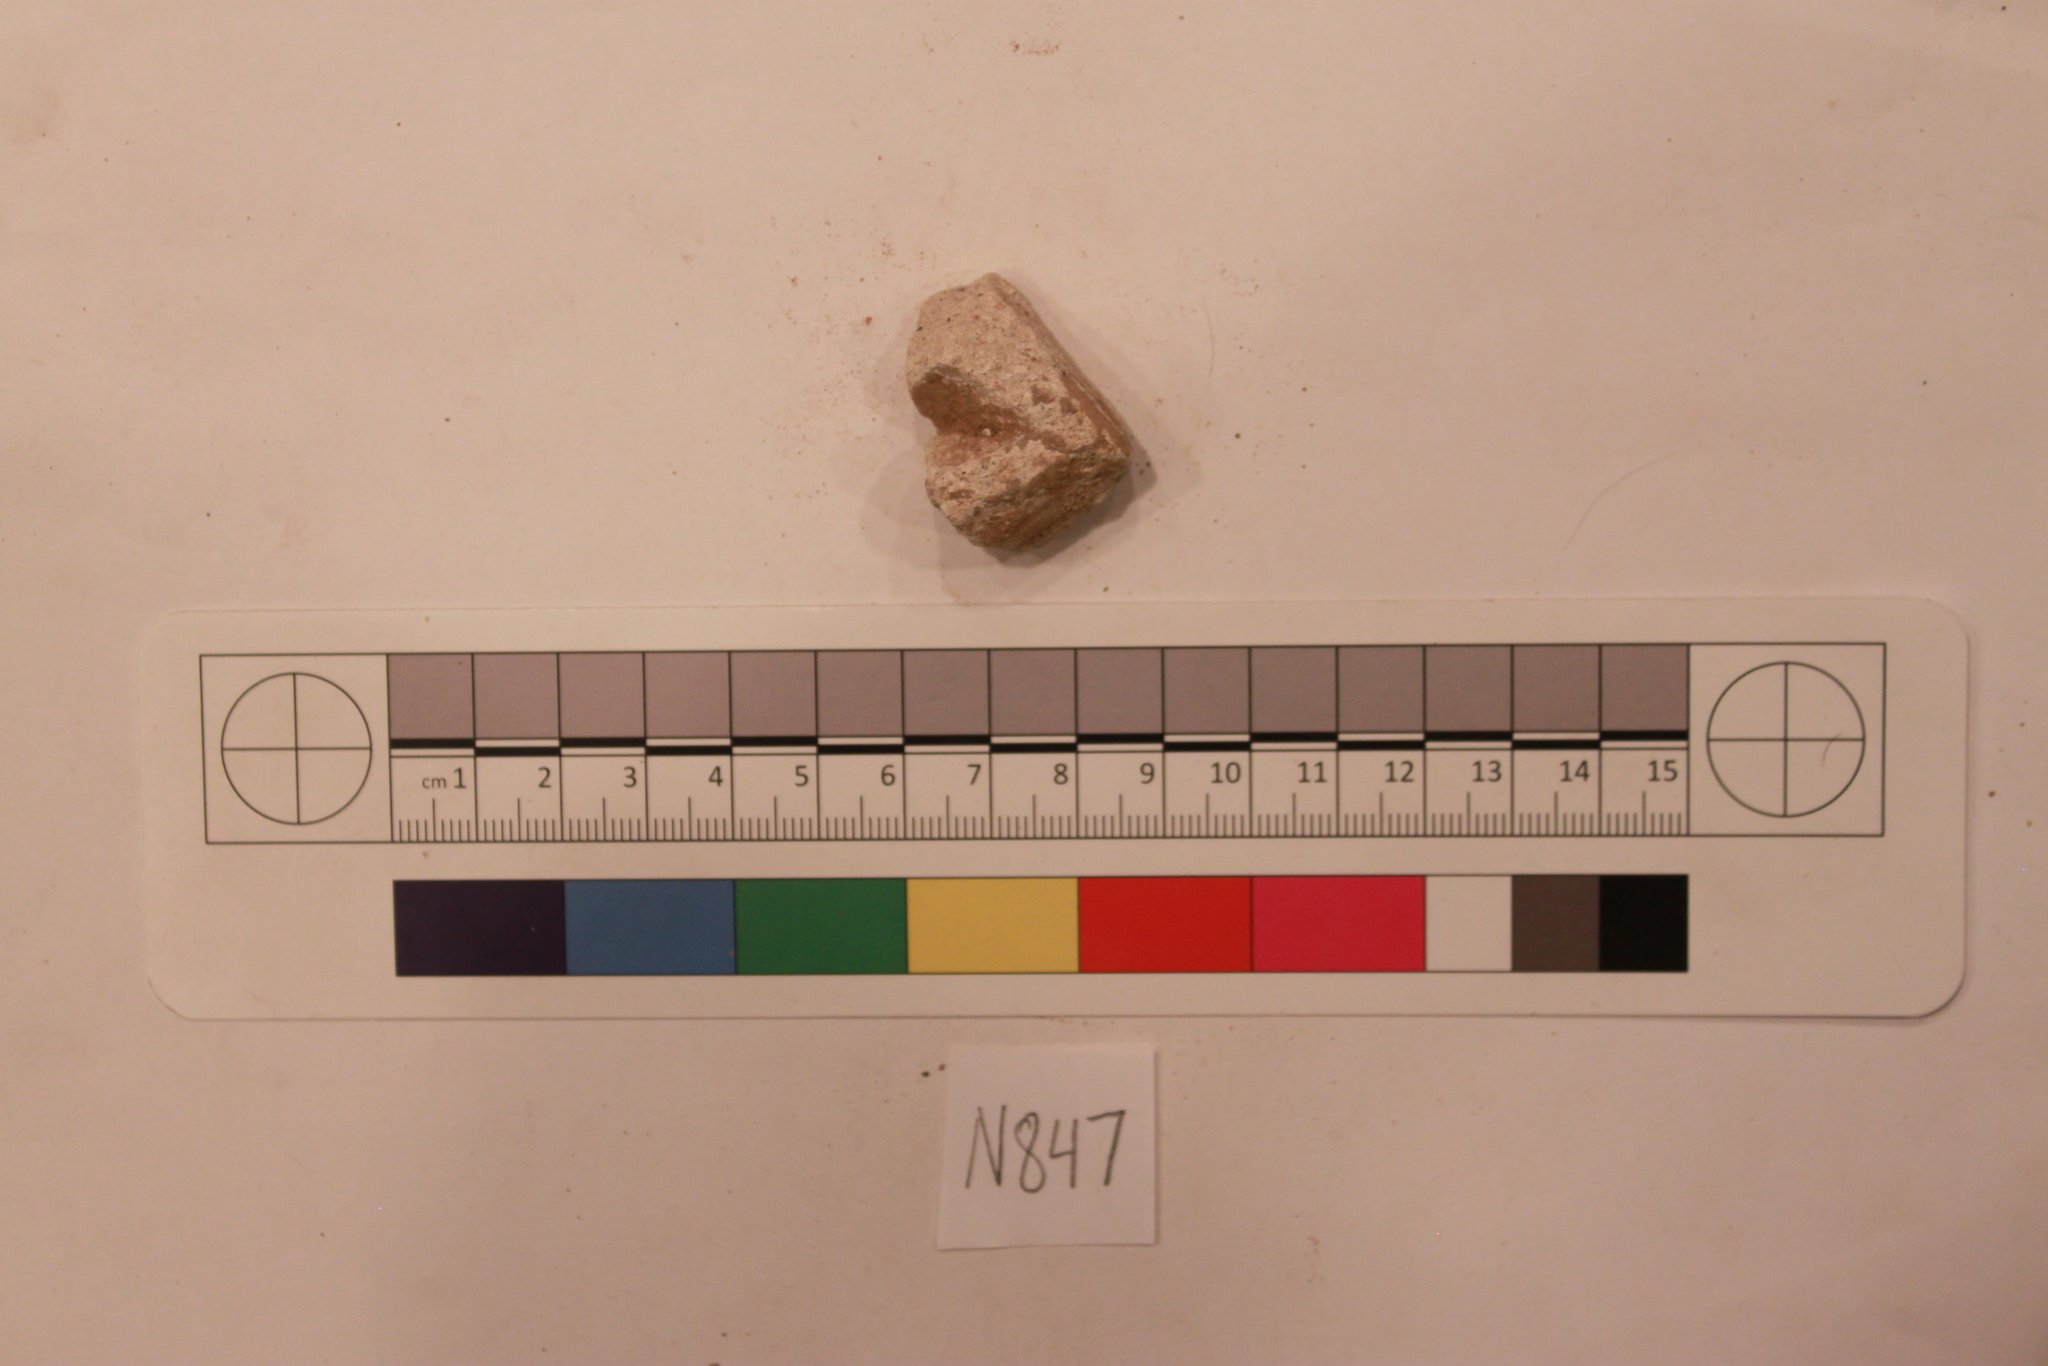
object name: fragment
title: Stucco Fragment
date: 701-1200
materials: plaster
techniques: carving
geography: iran